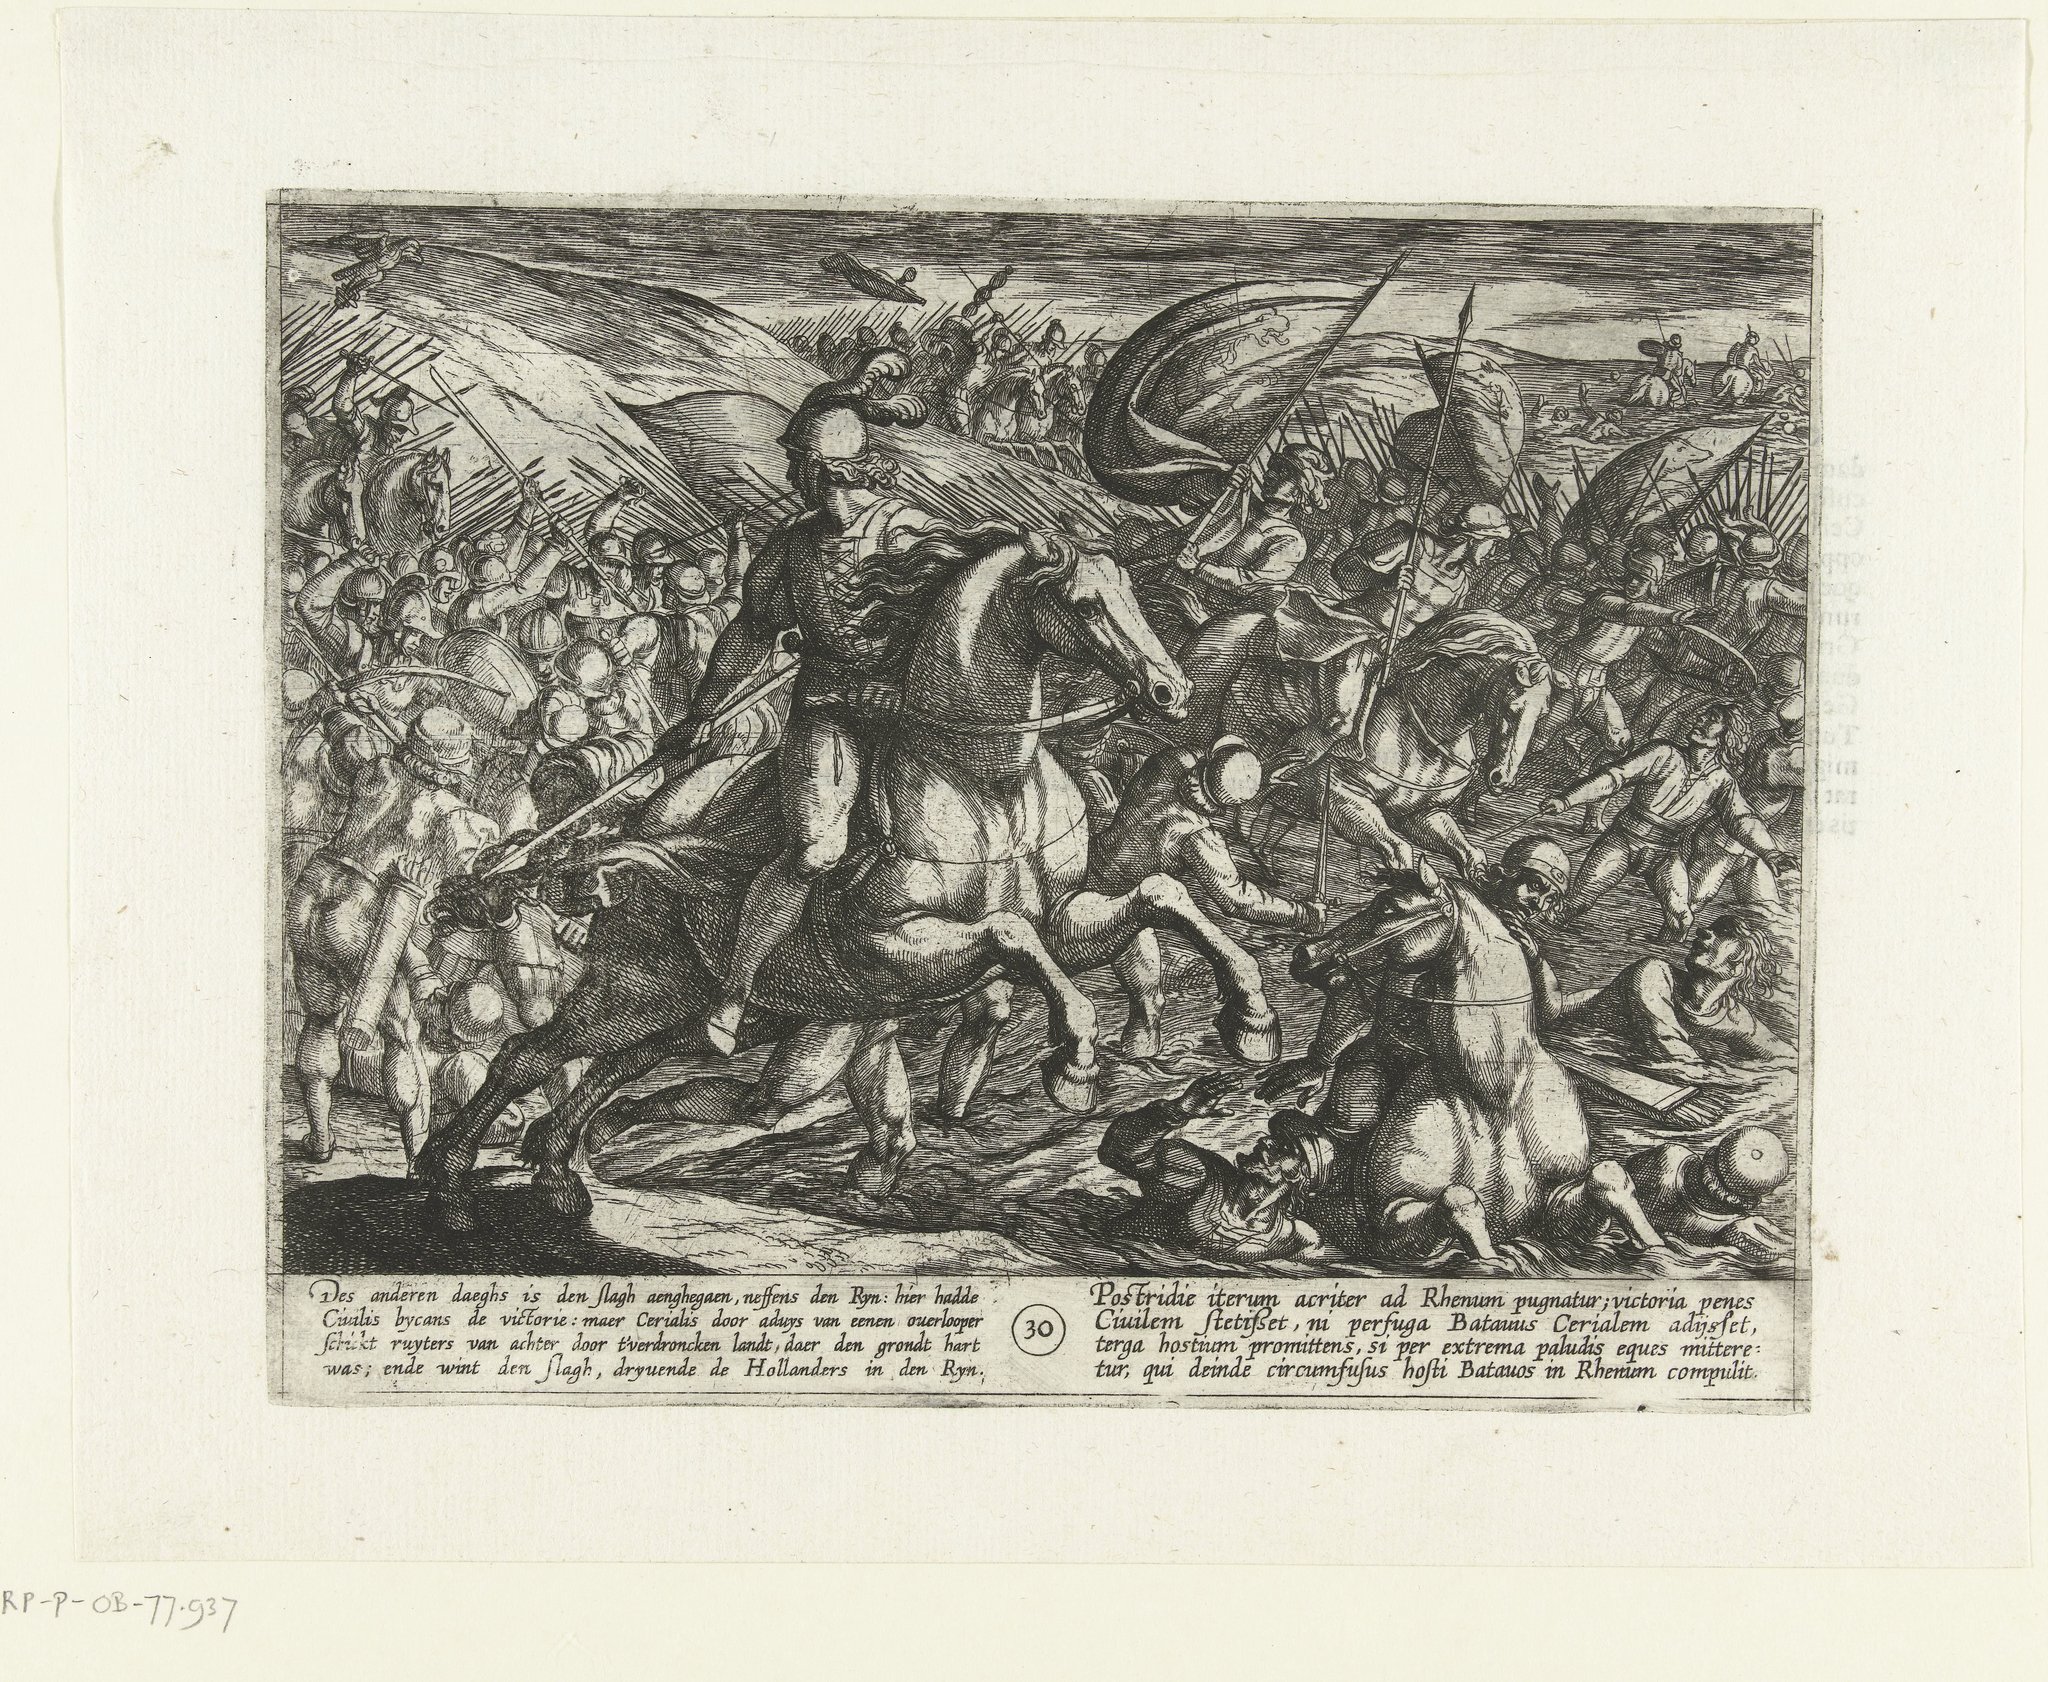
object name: print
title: Cerialis drijft de Bataven in de Rijn, 69-70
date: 1612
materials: paper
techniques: etching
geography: italy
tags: battle, fighting in general, extinct, 'historical' peoples (with name)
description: Cerialis drijft de Bataafse soldaten in het water van de Rijn. Prent nummer 30 in de serie prenten over de Bataafse Opstand: Batavorum cum Romanis bellum / à Corn. Tacito lib. IV & V. : Hist. olim descriptum, figuris nunc aeneis expressum, auctore Othone Vaenio Lugdunobatava = De Batavische oft oude Hollandtsche oorloghe teghen de Romeynen. Otto Vaenius, Antwerpen 1612. Onderaan twee verzen van vier regels in het Nederlands en in het Latijn. Op de achterzijde tekst in het Latijn.